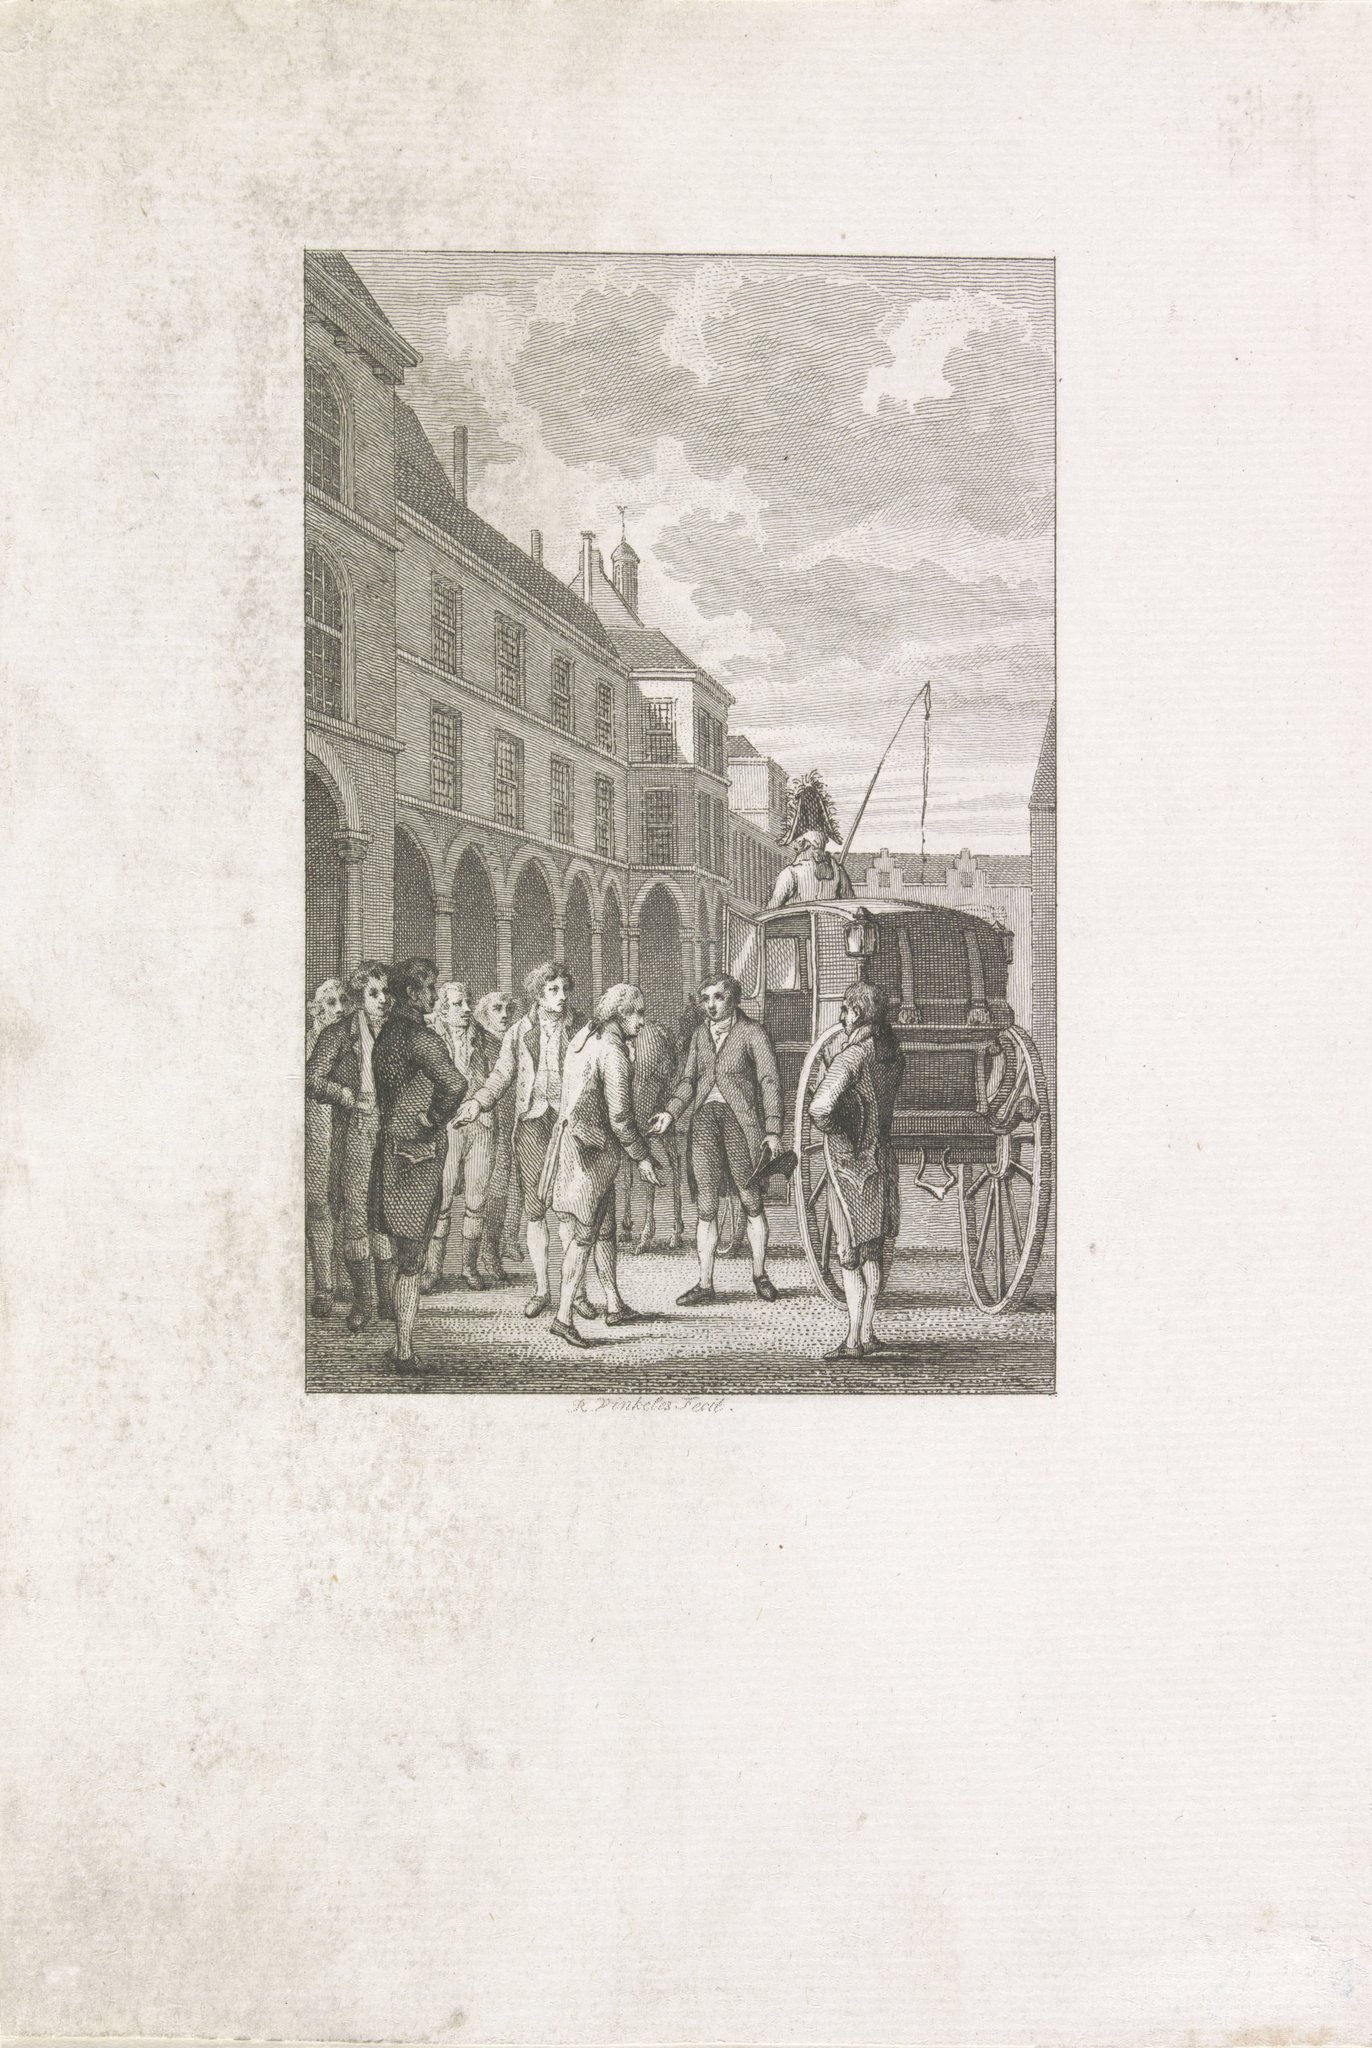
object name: print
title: Aankomst van R.J. Schimmelpenninck in Den Haag op 27 april 1805 als raadpensionaris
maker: reinier vinkeles (i)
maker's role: draughtsman, print maker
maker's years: 1741-1816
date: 1805-1812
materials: paper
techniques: engraving, etching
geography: netherlands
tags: deventer, amsterdam, rutger jan schimmelpenninck (1761-1825), being welcomed ~ travelling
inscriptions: collector's mark: Lugt 2228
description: Aankomst van Mr. R.J. Schimmelpenninck in Den Haag op 27 april 1805 als raadpensionaris van het Bataafs Gemenebest. Hij wordt bij het verlaten van zijn rijtuig op het Binnenhof opgewacht en begroet.